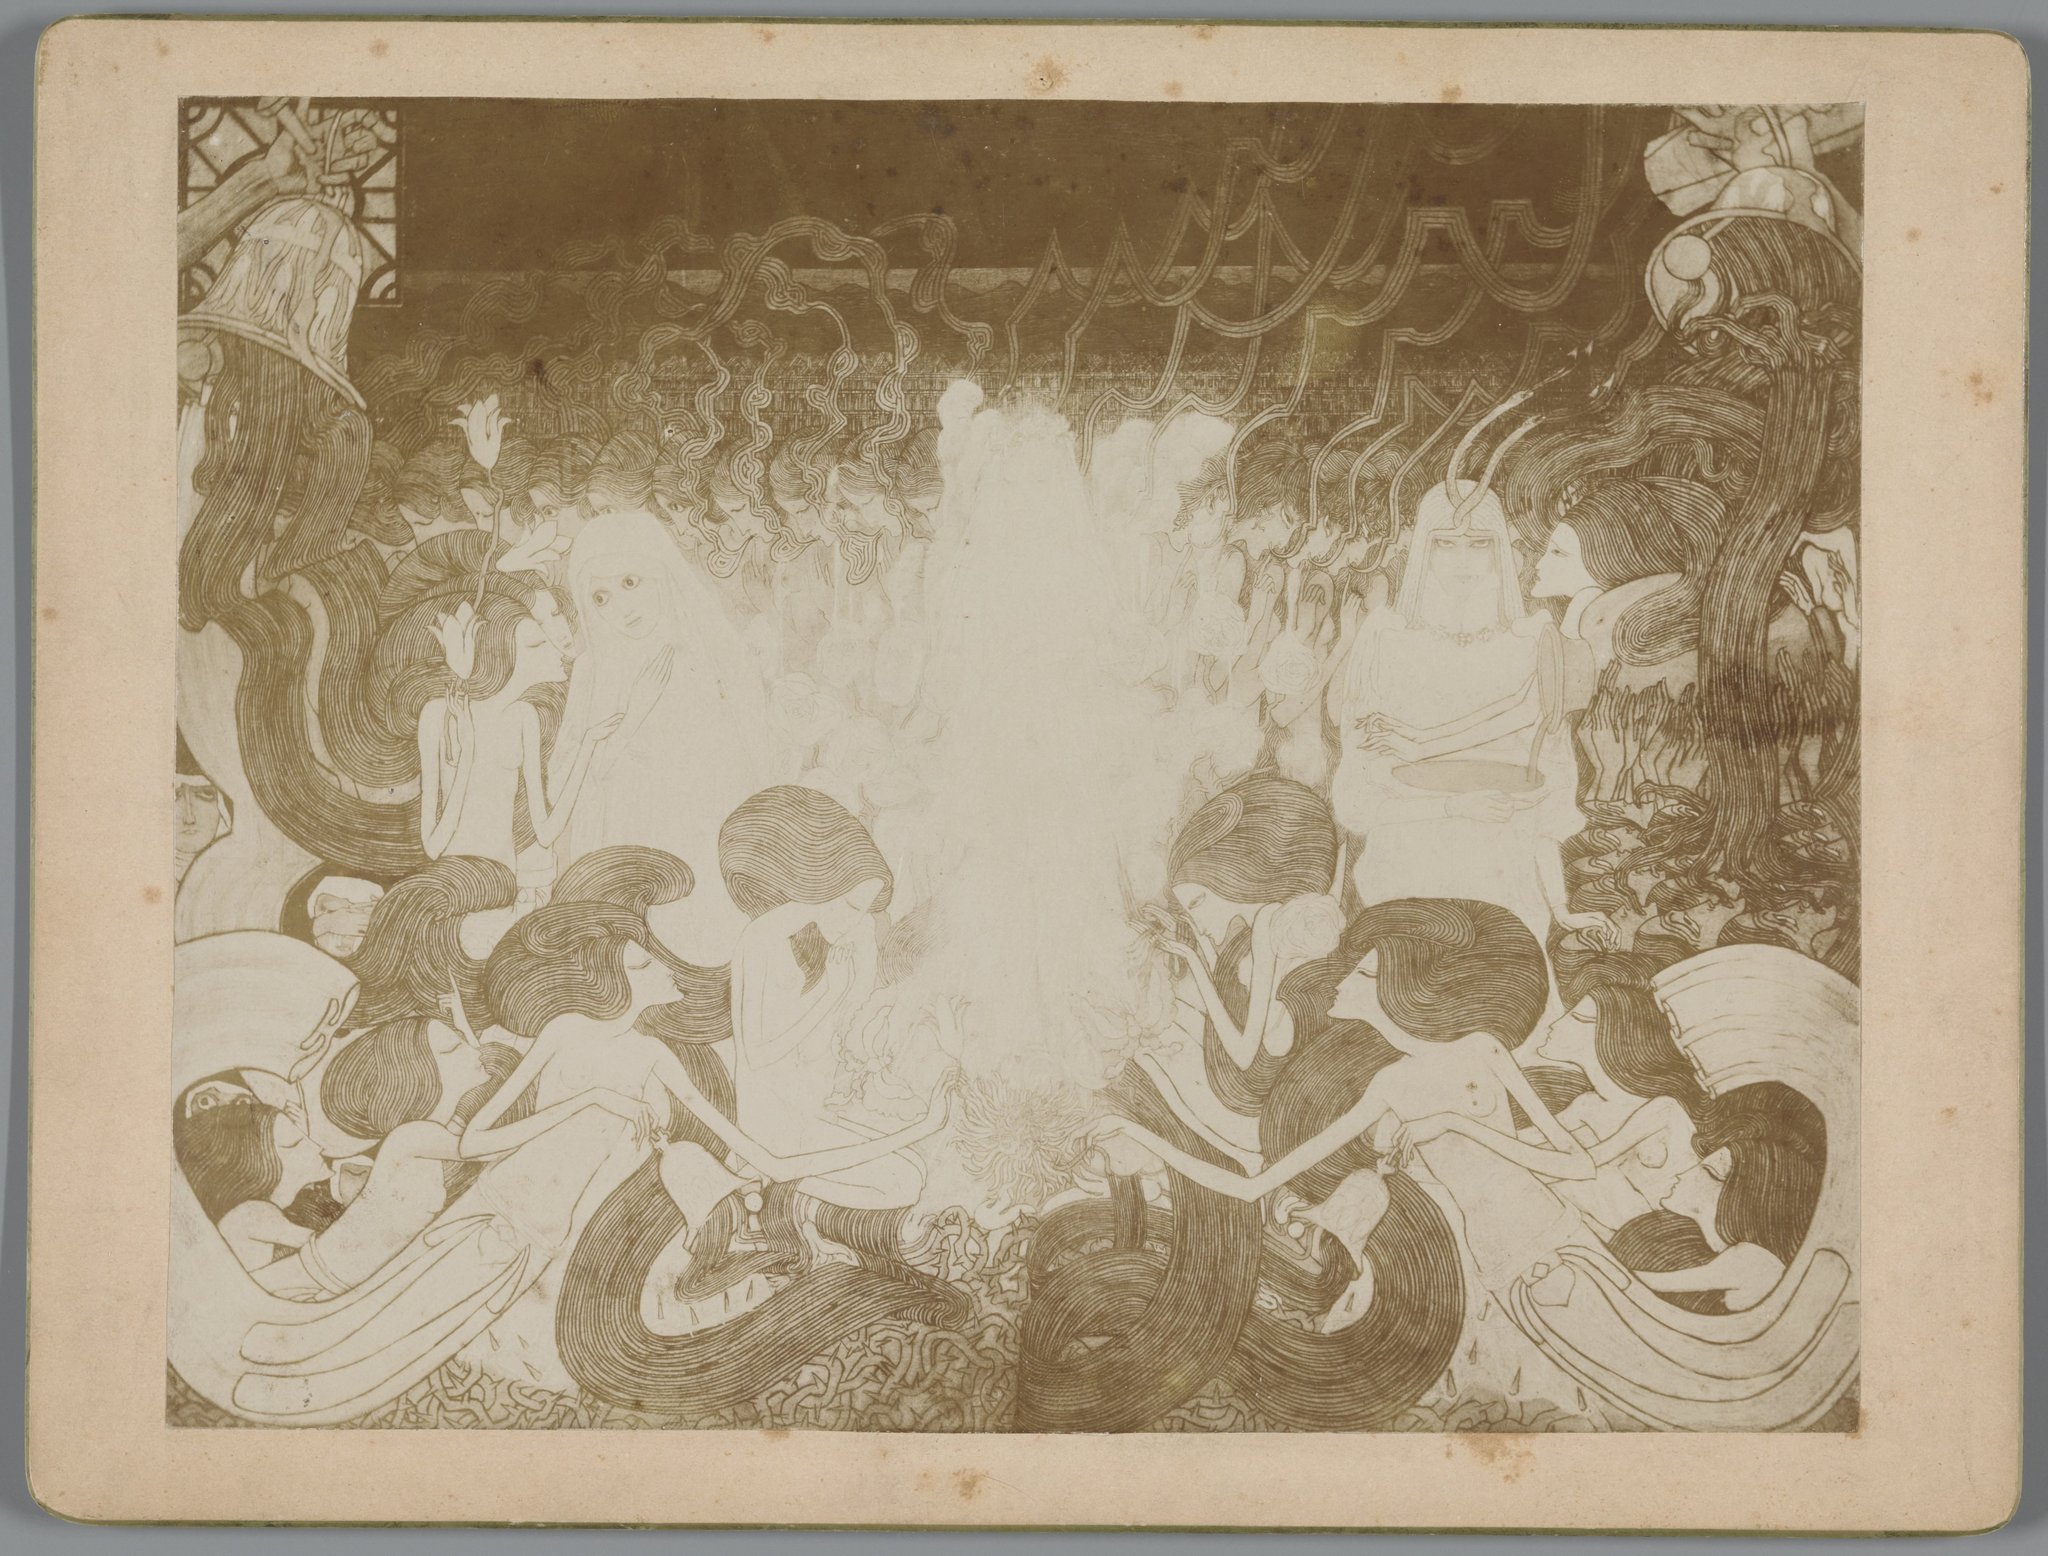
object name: photograph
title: Reproductie naar een schilderij van Jan Toorop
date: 1860-1915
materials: cardboard, paper, photographic support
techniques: gelatin silver print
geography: netherlands